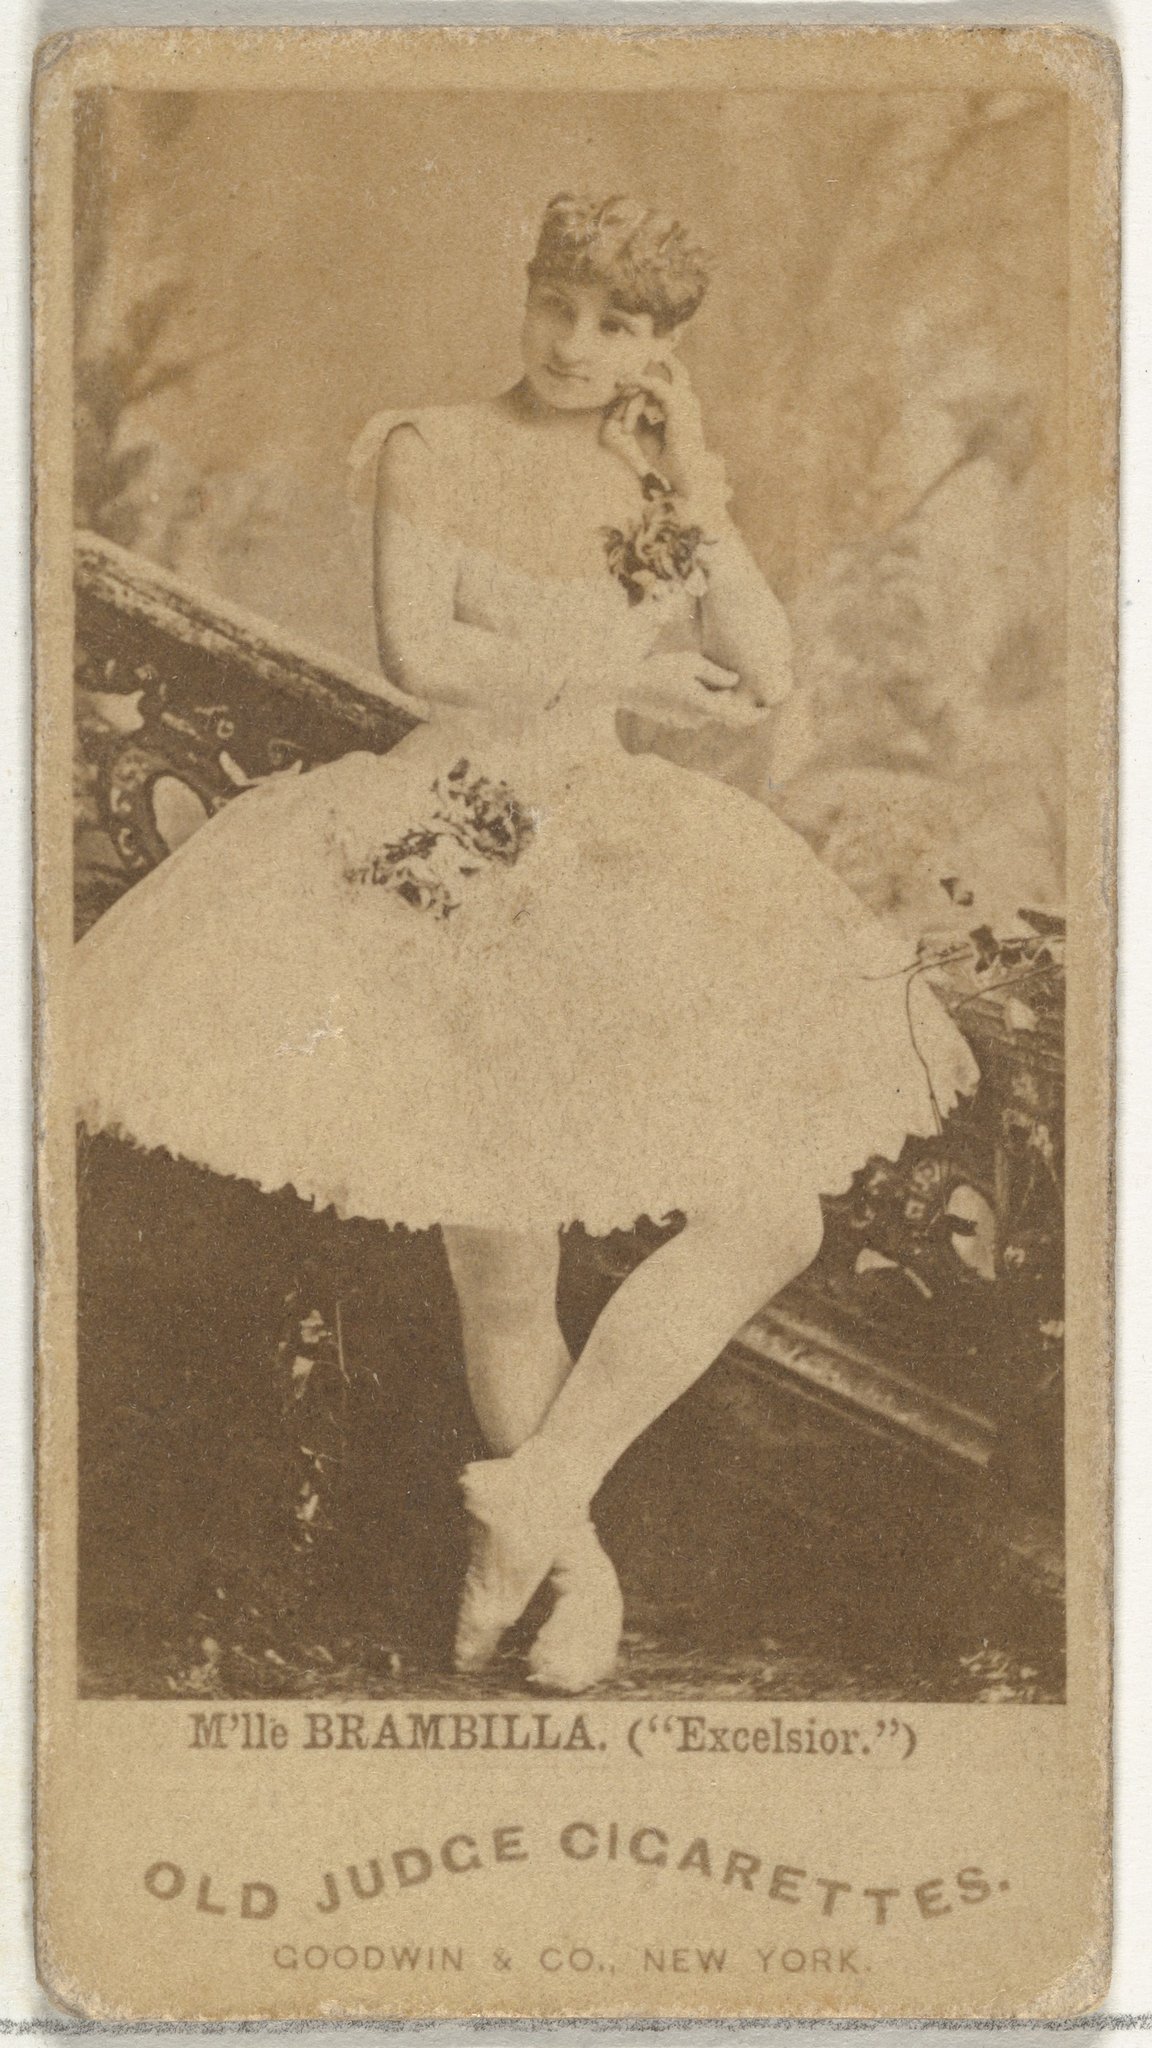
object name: photograph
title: Mlle. Brambilla in "Excelsior", from the Actors and Actresses series (N171) for Old Judge Cigarettes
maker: goodwin & company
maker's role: publisher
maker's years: 1850-1950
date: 1886-1890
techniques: albumen silver print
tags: portraits,women,actresses